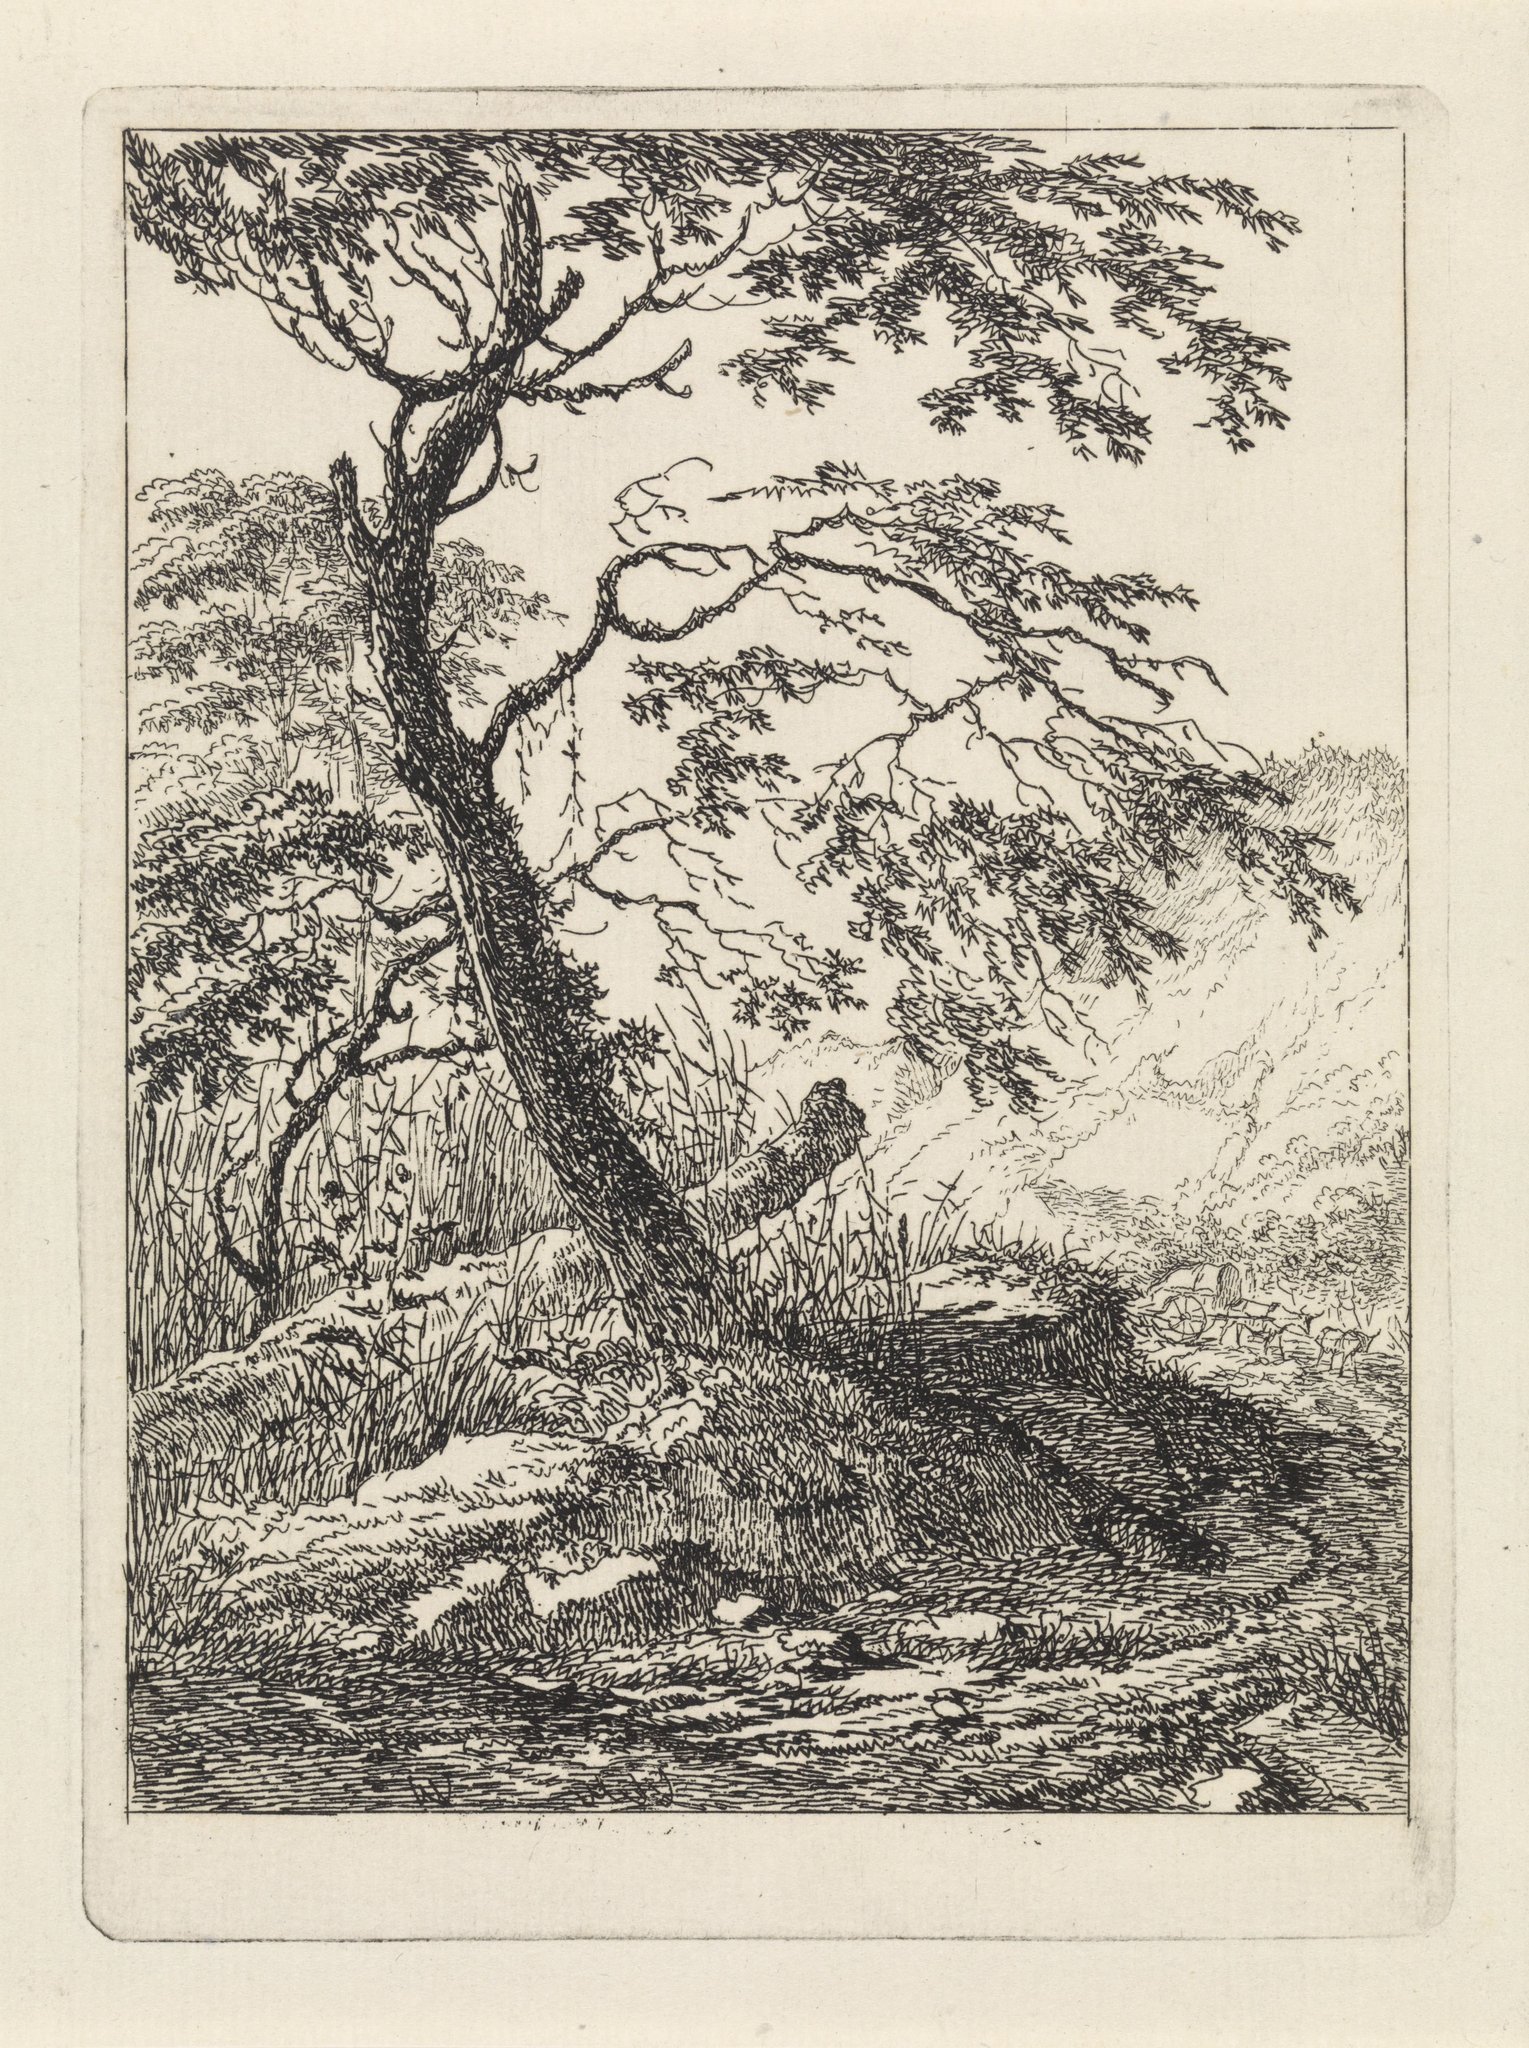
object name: print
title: Landschappen (serie B)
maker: gerard van nijmegen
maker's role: draughtsman, painter, print maker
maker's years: 1735-1808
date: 1790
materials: paper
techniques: etching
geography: rotterdam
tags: trees, two-wheeled vehicle drawn by two animals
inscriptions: collector's mark: Lugt 2228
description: Een boom langs een weg. Op de achtergrond rijdt een kar getrokken door twee dieren over de weg.